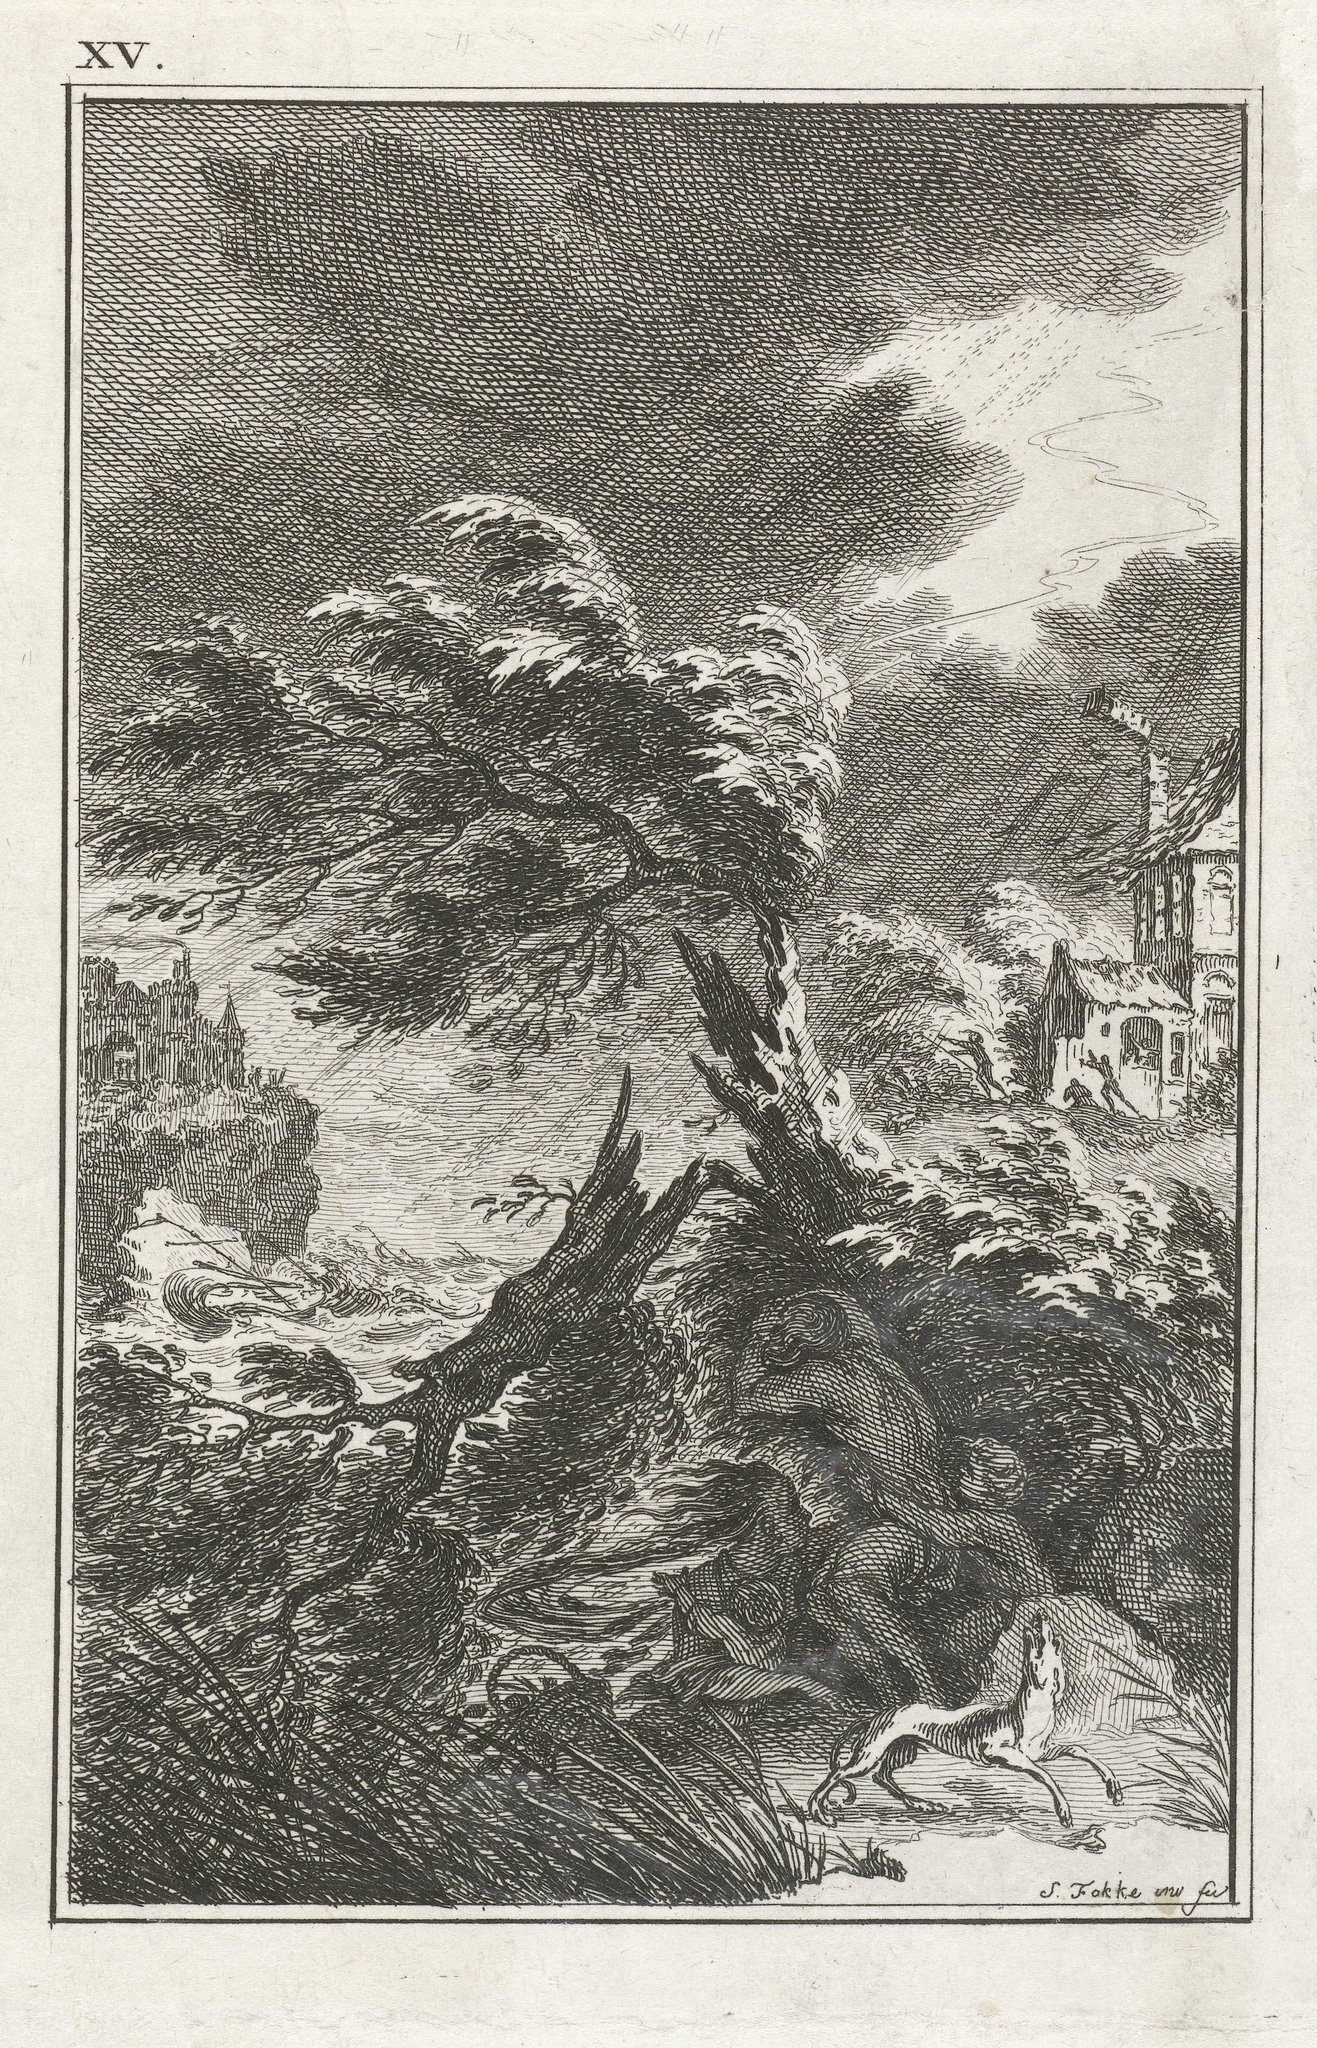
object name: book illustration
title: Figuren in een storm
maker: simon fokke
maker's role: draughtsman, print maker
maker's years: 1712-1784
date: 1722-1784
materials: paper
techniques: etching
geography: amsterdam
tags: storm, dog (+ audible means of communication of animal(s): roaring, crying, singing, barking, mewing, neighing, chirping, etc.)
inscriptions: collector's mark: Lugt 2228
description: Twee volwassenen en twee kinderen zitten ineengedoken onder een omgewaaide boom. In de verte waait rechts een schoorsteen van een huis en wordt links een zeilschip bedolven onder hoge golven. Op de voorgrond jankt een hond. Prent linksboven gemerkt: XV.